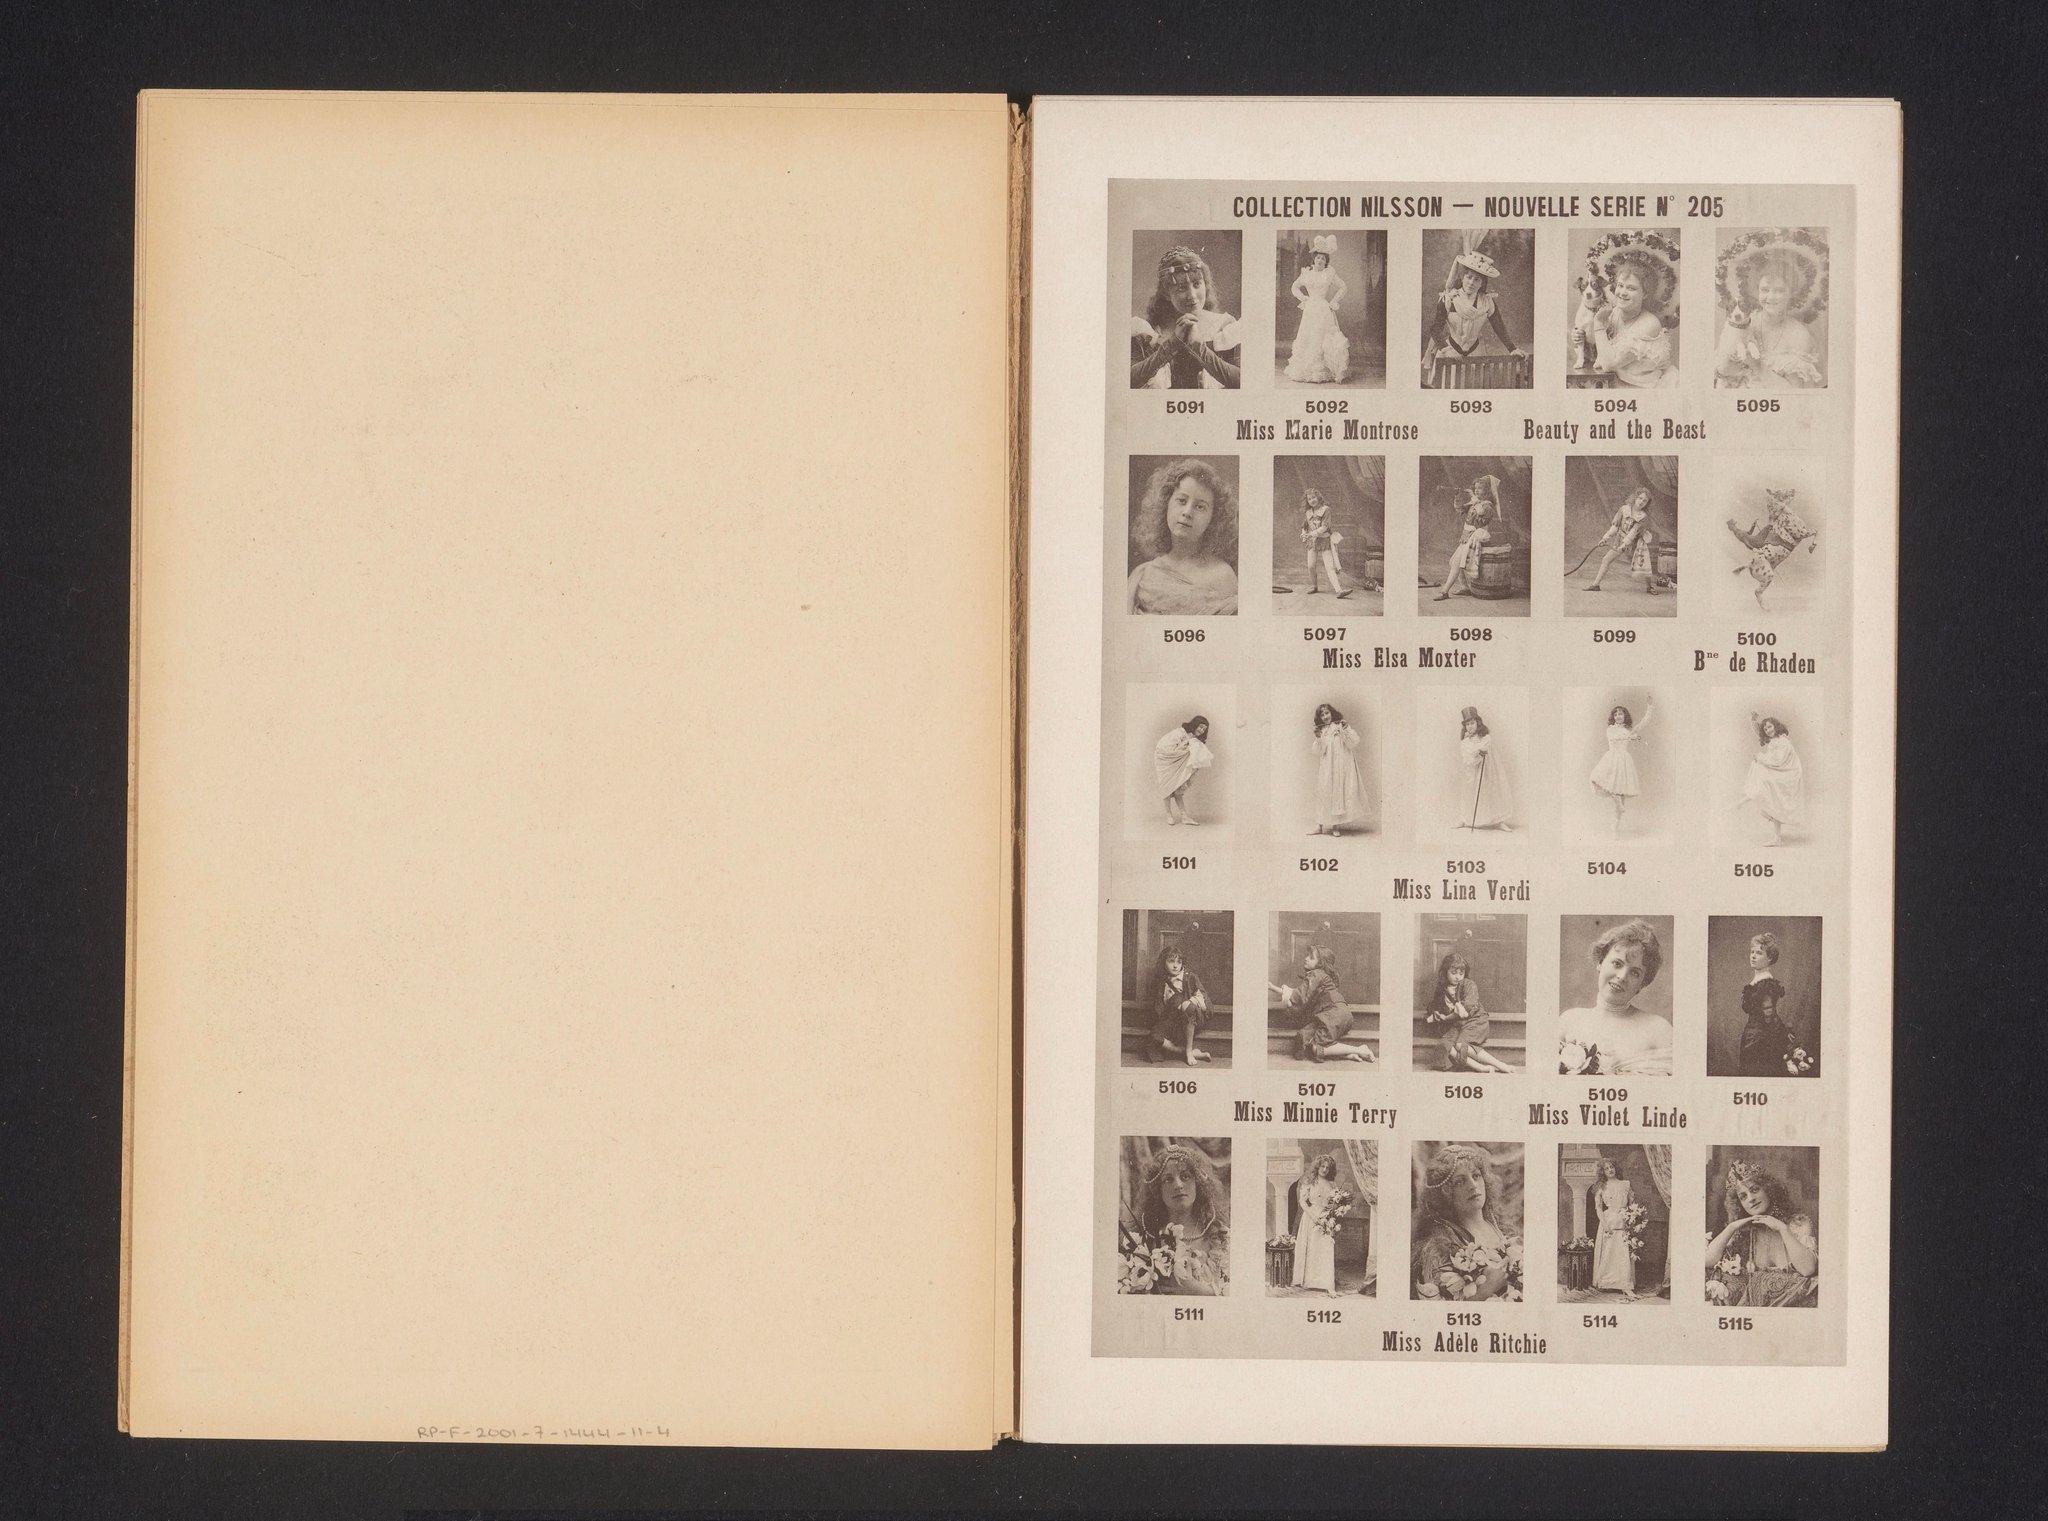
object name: page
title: 25 portretten van Marie Montrose, Elsa Moxter, Lina Verdi, Minnie Terry, Violet Linde en Adèle Ritchie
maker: Anonymous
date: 1894-1899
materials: paper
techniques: photograph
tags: historical persons - bb - woman, portrait of opera-singer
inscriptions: inscription: ‘Miss Marie Montrose Beauty and the Beast/ Miss Elsa Moxter Bne de Rhaden/ Miss Lina Verdi/ Miss Minnie Terry Miss Violet Linde/ Miss Adèle Ritchie’, number: ‘No 205’